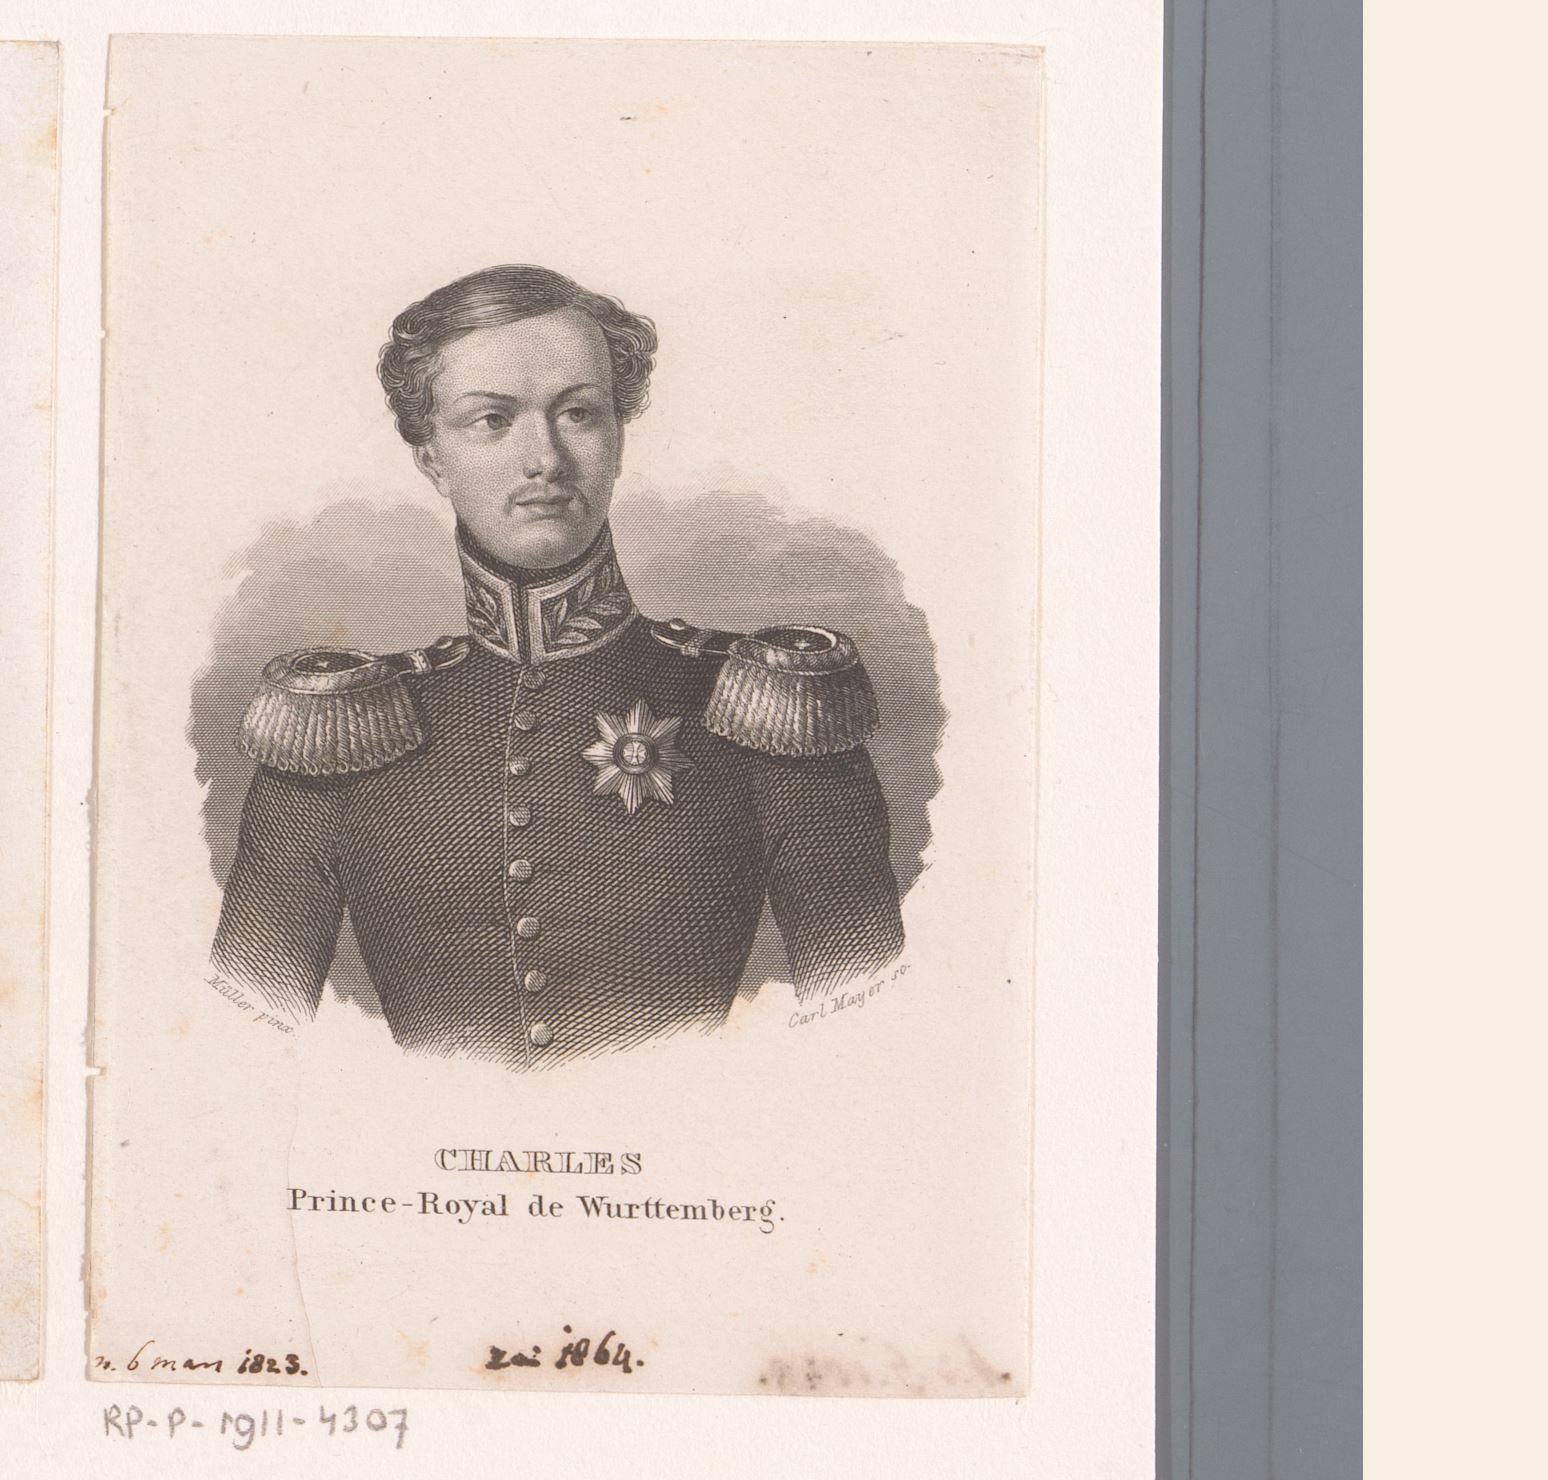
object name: book illustration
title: Portret van prins Karl von Württemberg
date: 1849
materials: paper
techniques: engraving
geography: nuremberg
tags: historical persons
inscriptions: collector's mark: Lugt 2228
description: Vermoedelijk afkomstig uit: Almanach de Gotha, 1849.